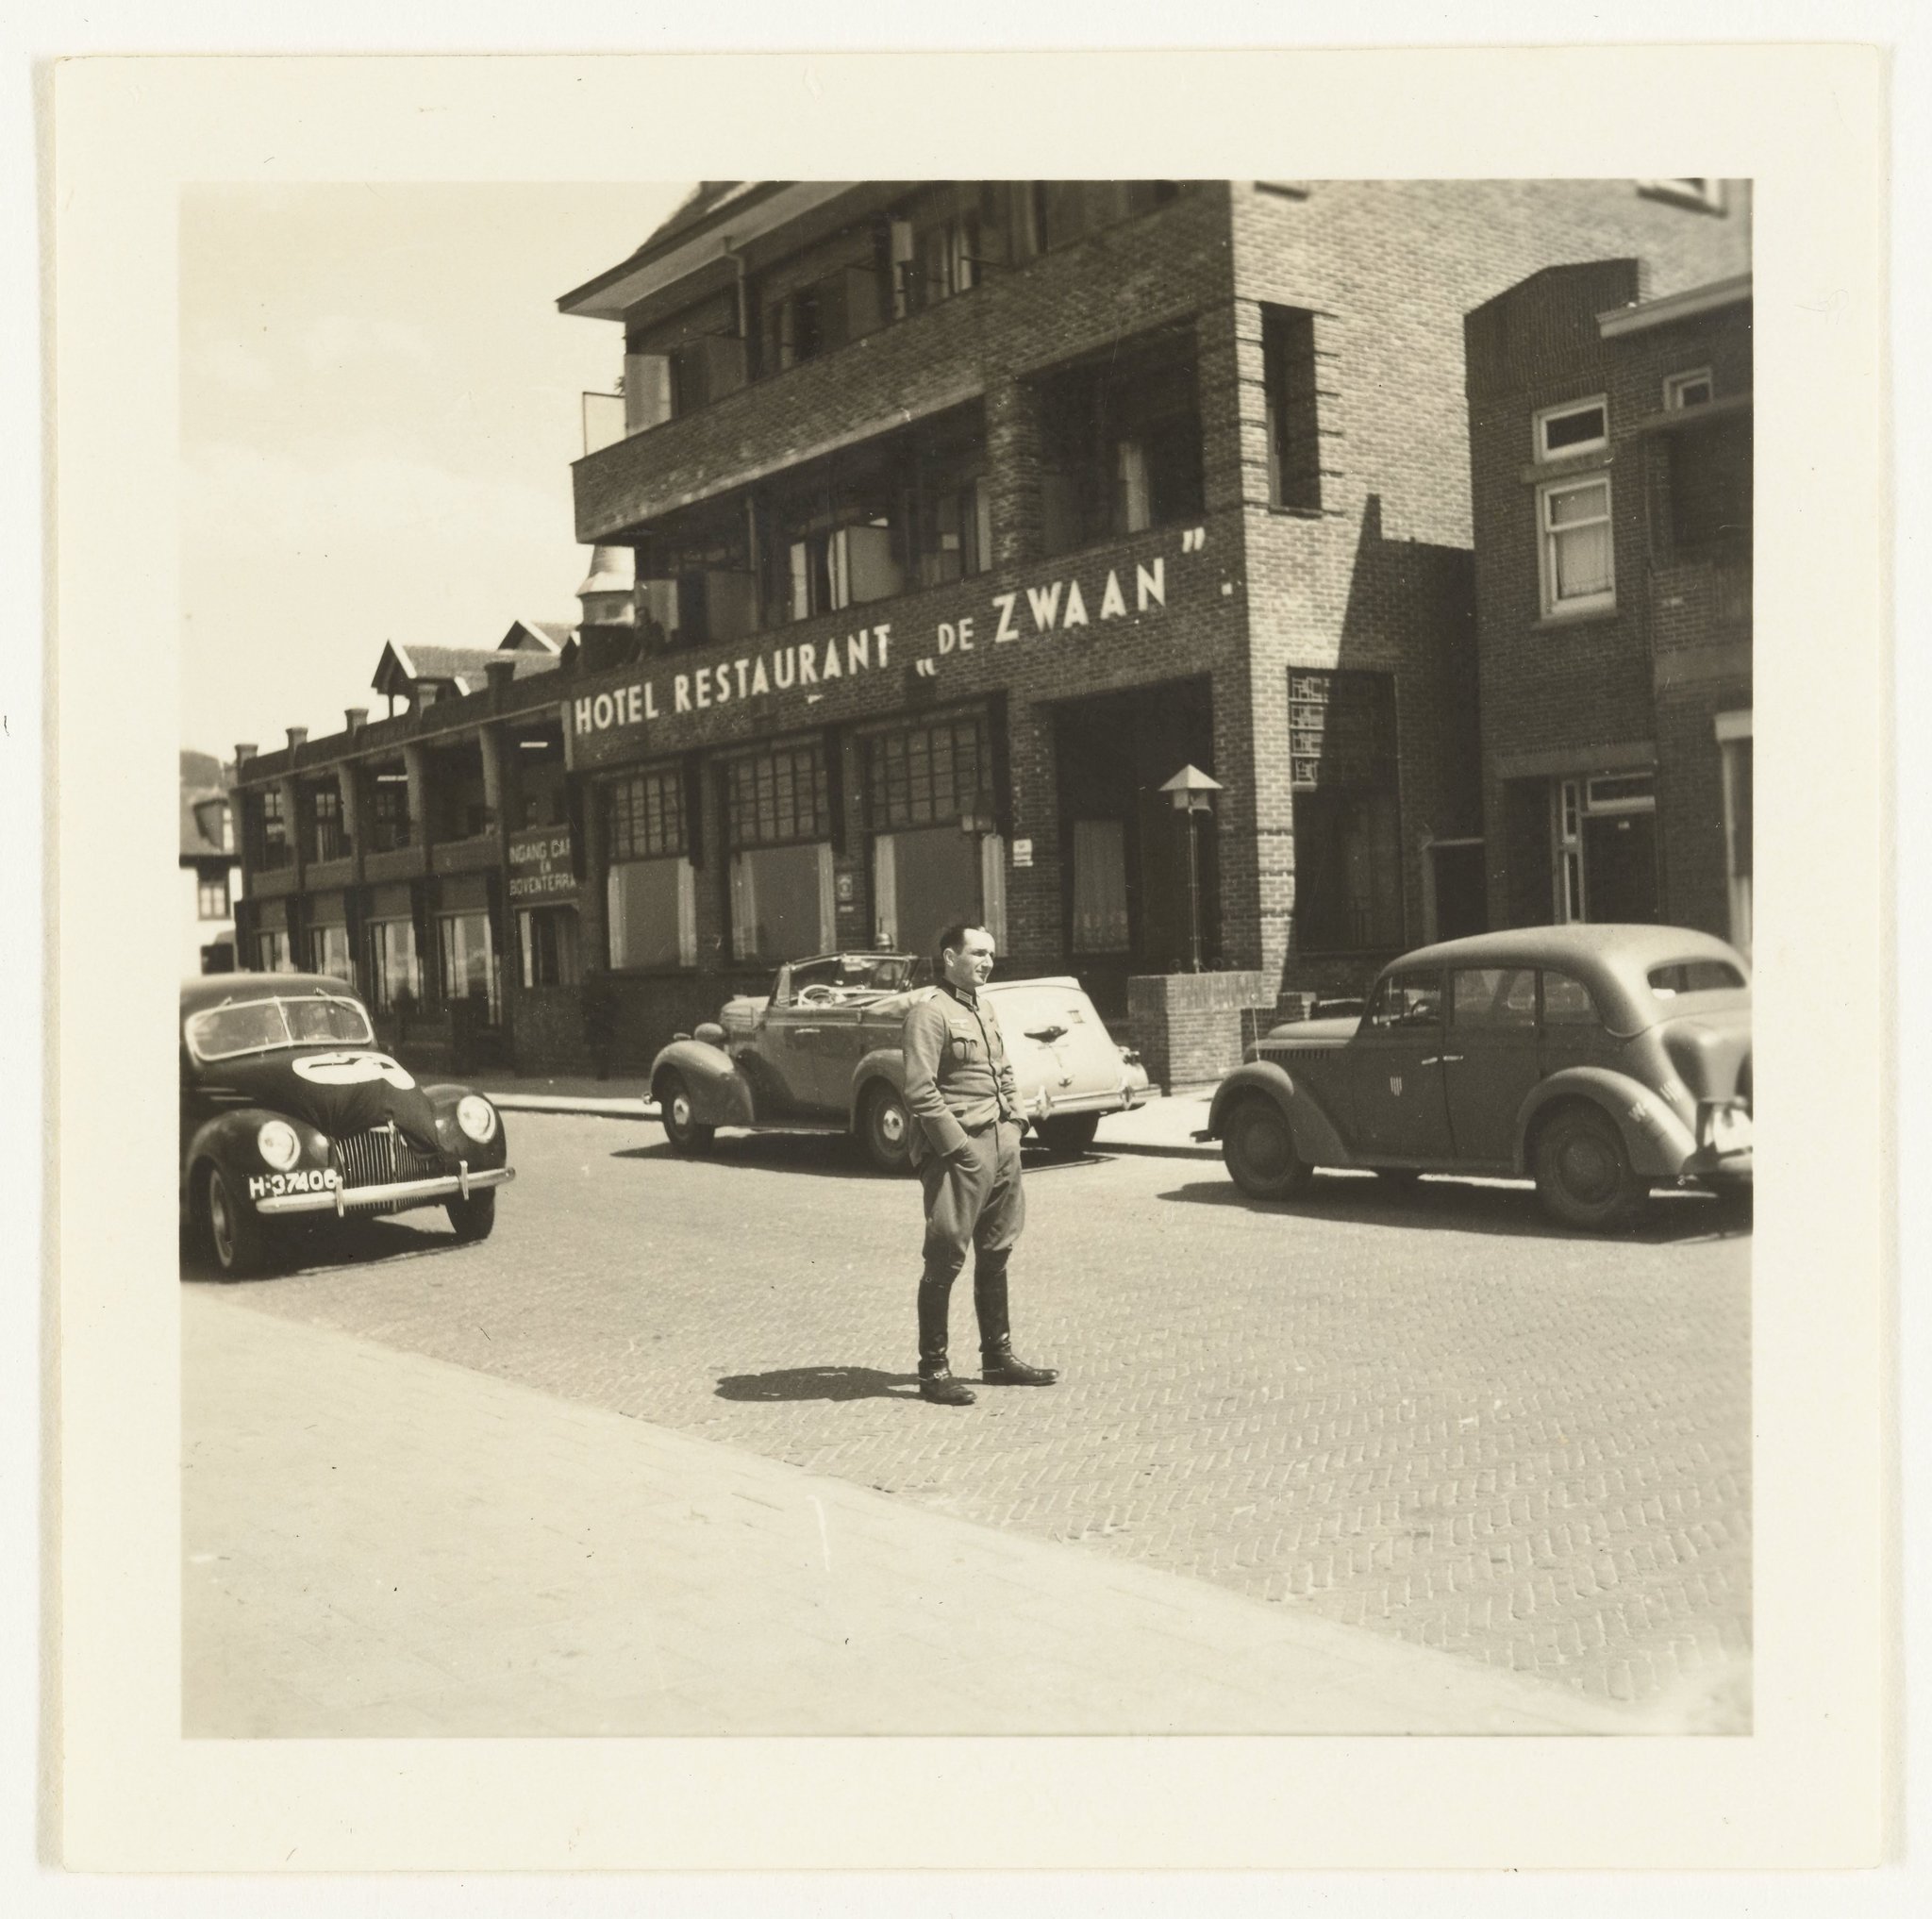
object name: photograph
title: Duitse soldaat op straat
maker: Anonymous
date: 1940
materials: photographic support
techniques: gelatin silver print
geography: katwijk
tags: occupation ~ war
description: Midden op straat staat een Duitse Wehrmachtsoldaat, blootshoofd. Achter hem een paar geparkeerde auto's (nummerbord begint met een H) en een gebouw met het opschrift: Hotel Restaurant "De Zwaan ". Achterop staat: Katwijk am See, Holland am 16. 5. 40. Der Retter von Katwijk.